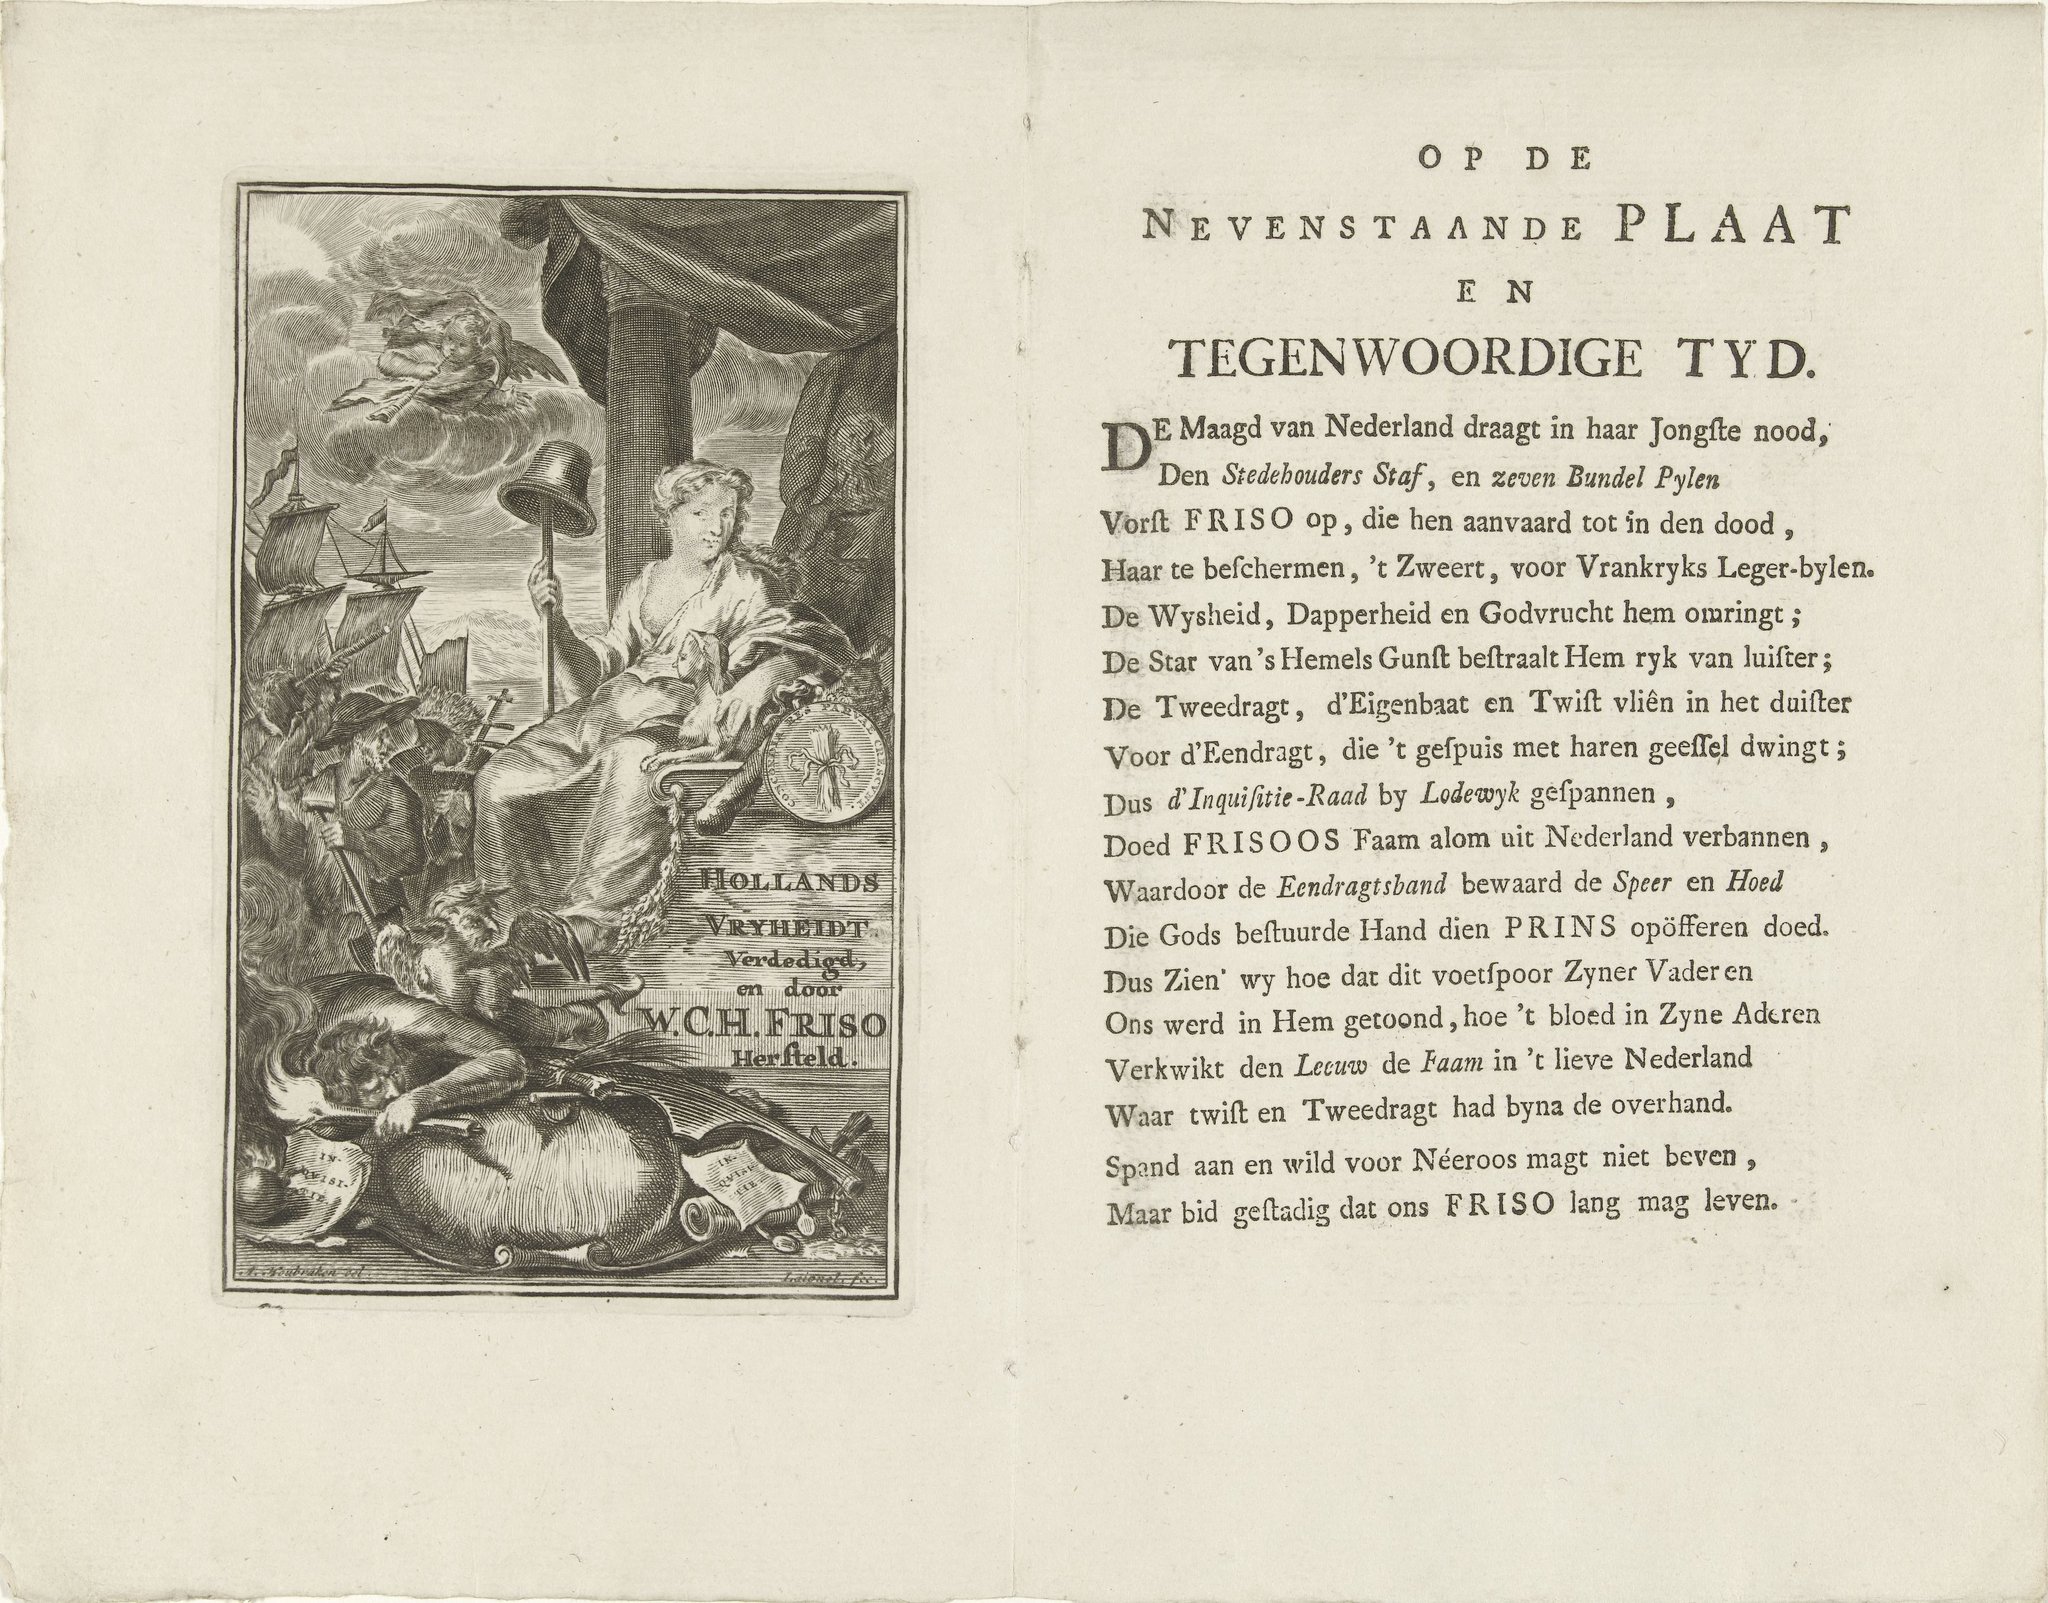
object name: print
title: Allegorie op de verheffing van Willem IV tot stadhouder in 1747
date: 1747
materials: paper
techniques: engraving, letterpress printing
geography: northern netherlands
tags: the hague, willem iv (prins van oranje-nassau), personifications of countries, nations, states, districts, etc., netherlands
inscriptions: collector's mark: Lugt 2228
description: Allegorie op de installatie van Willem IV als stadhouder in 1747. De Nederlandse Maagd gezeten op een troon met lans en vrijheidshoed. Op de voorgrond symbolen van Tweedracht en de Franse Inquisitie. Op de achtergrond zeelieden en schepen. Op het blad naast de plaat staat een verklaring van de voorstelling in versvorm.